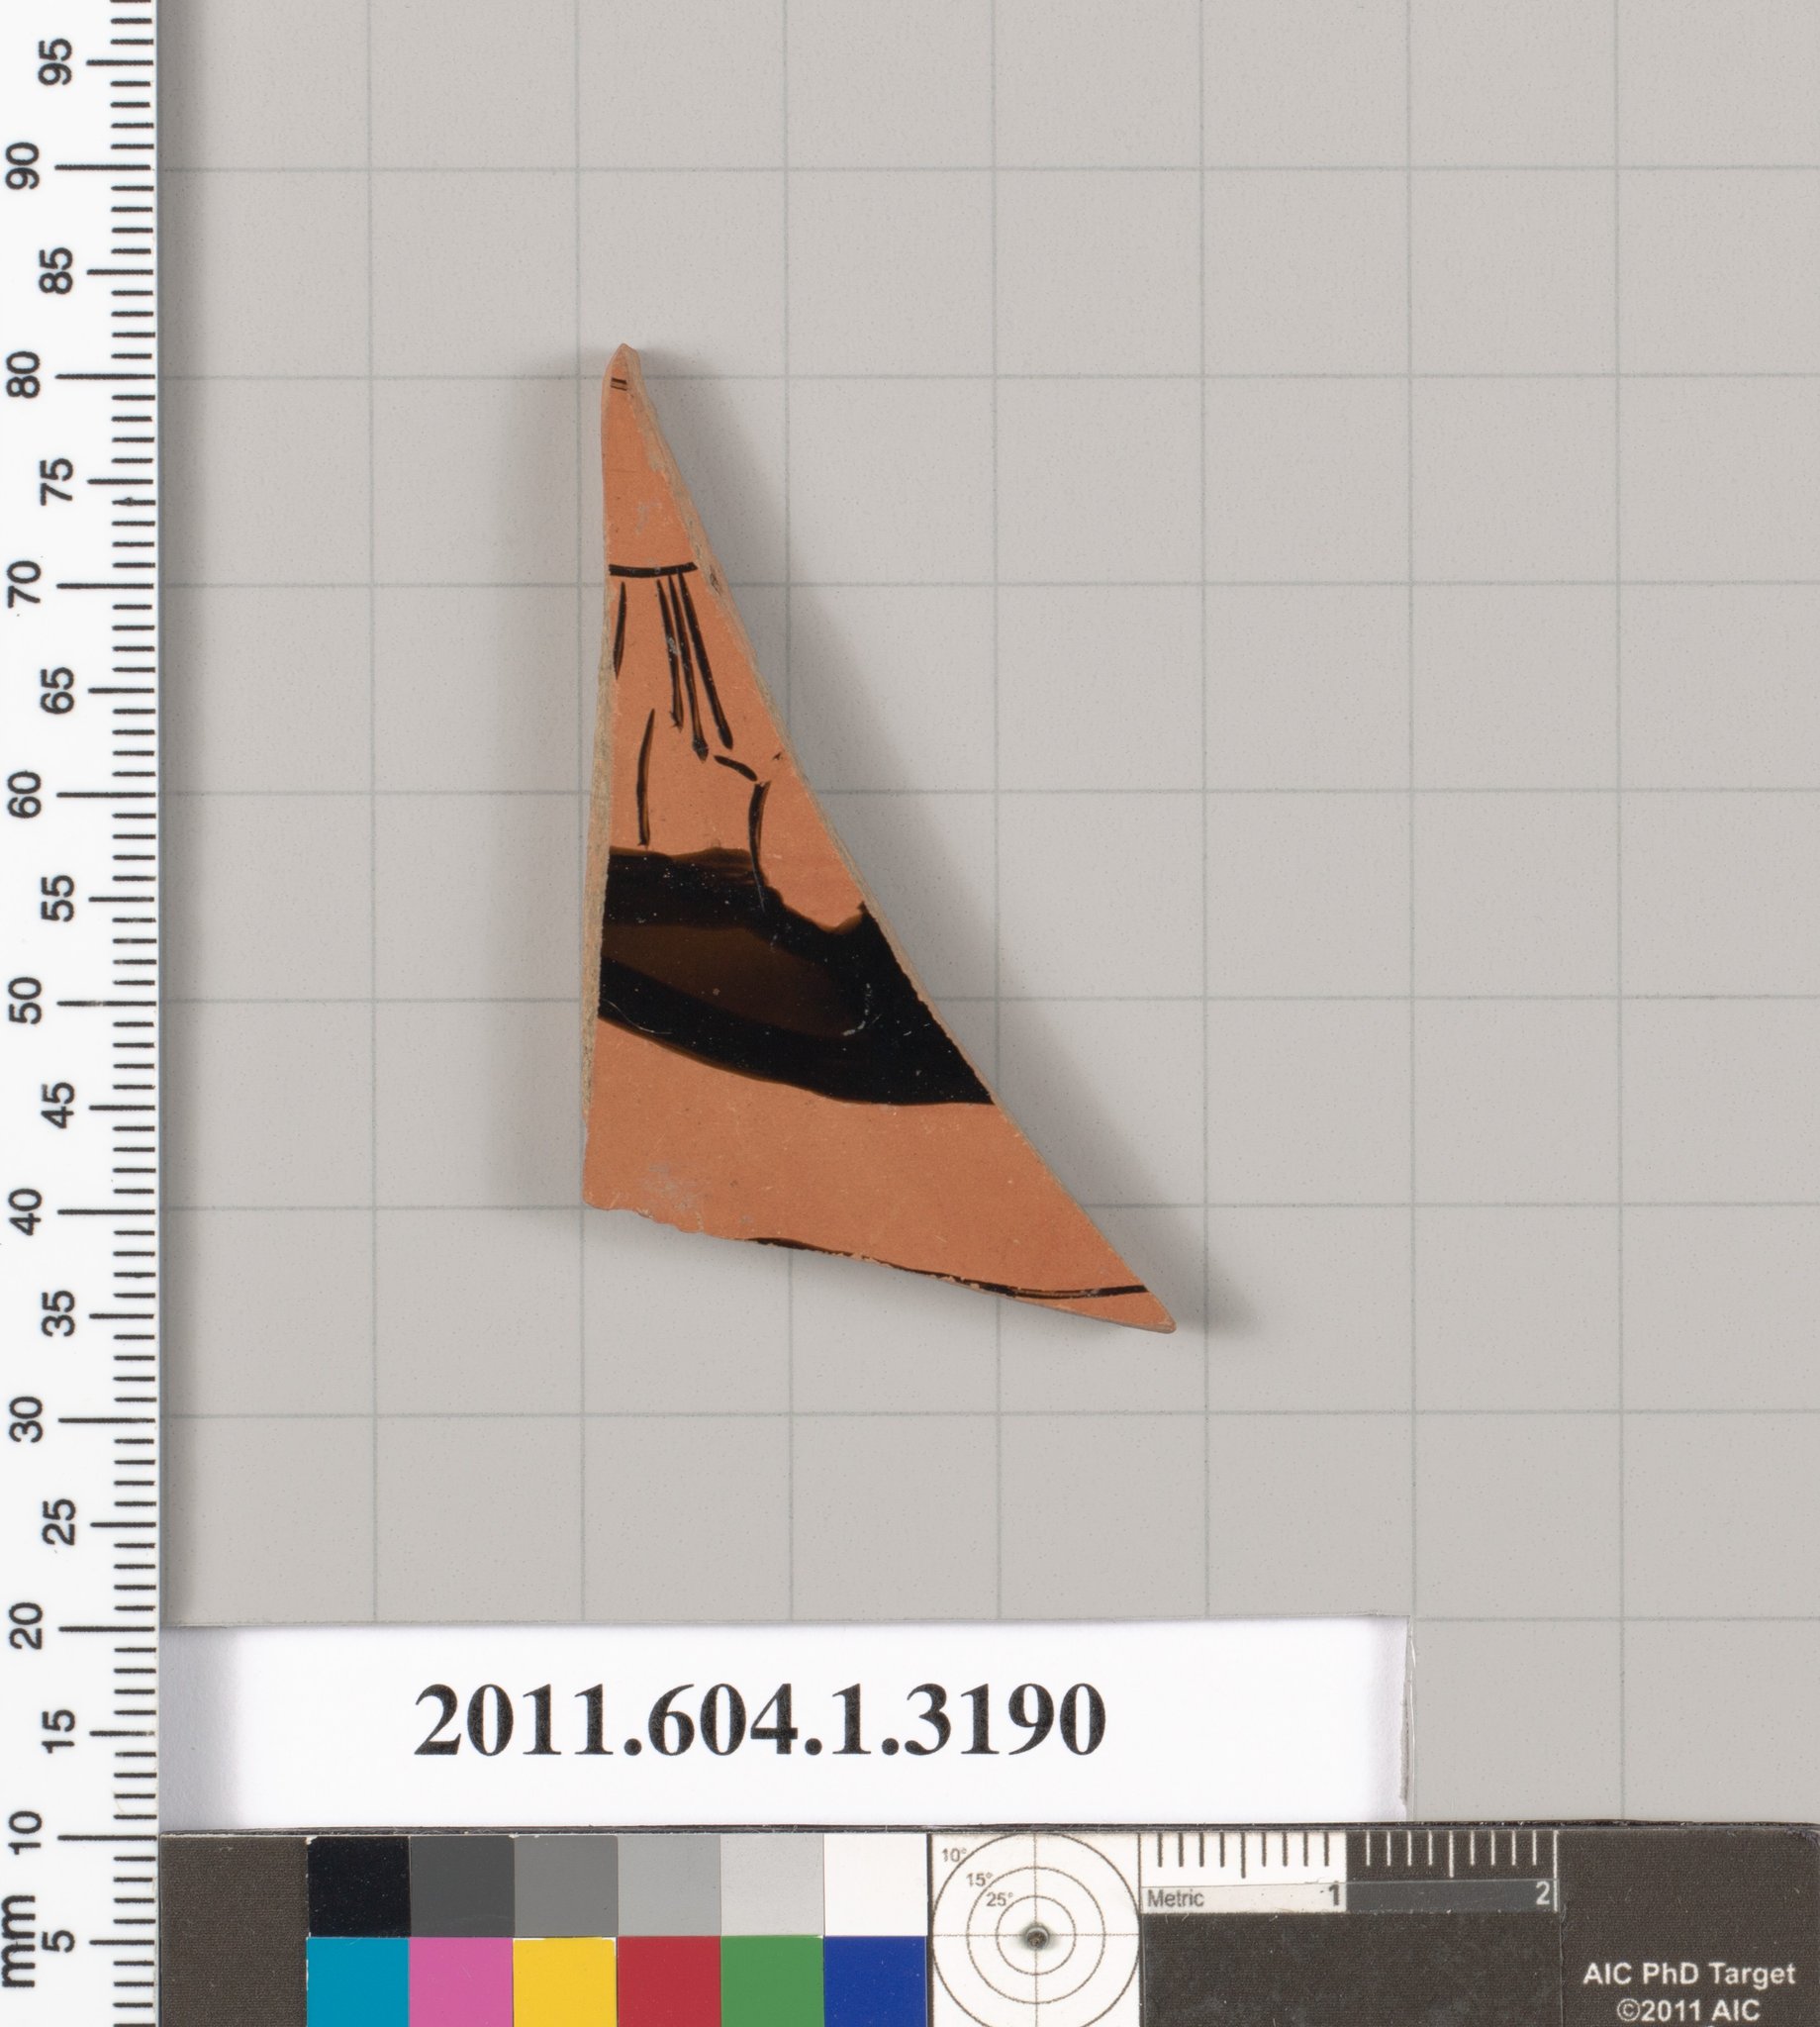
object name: kylix fragment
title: Terracotta fragment of a kylix (drinking cup)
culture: greek, attic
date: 475-451 BCE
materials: terracotta